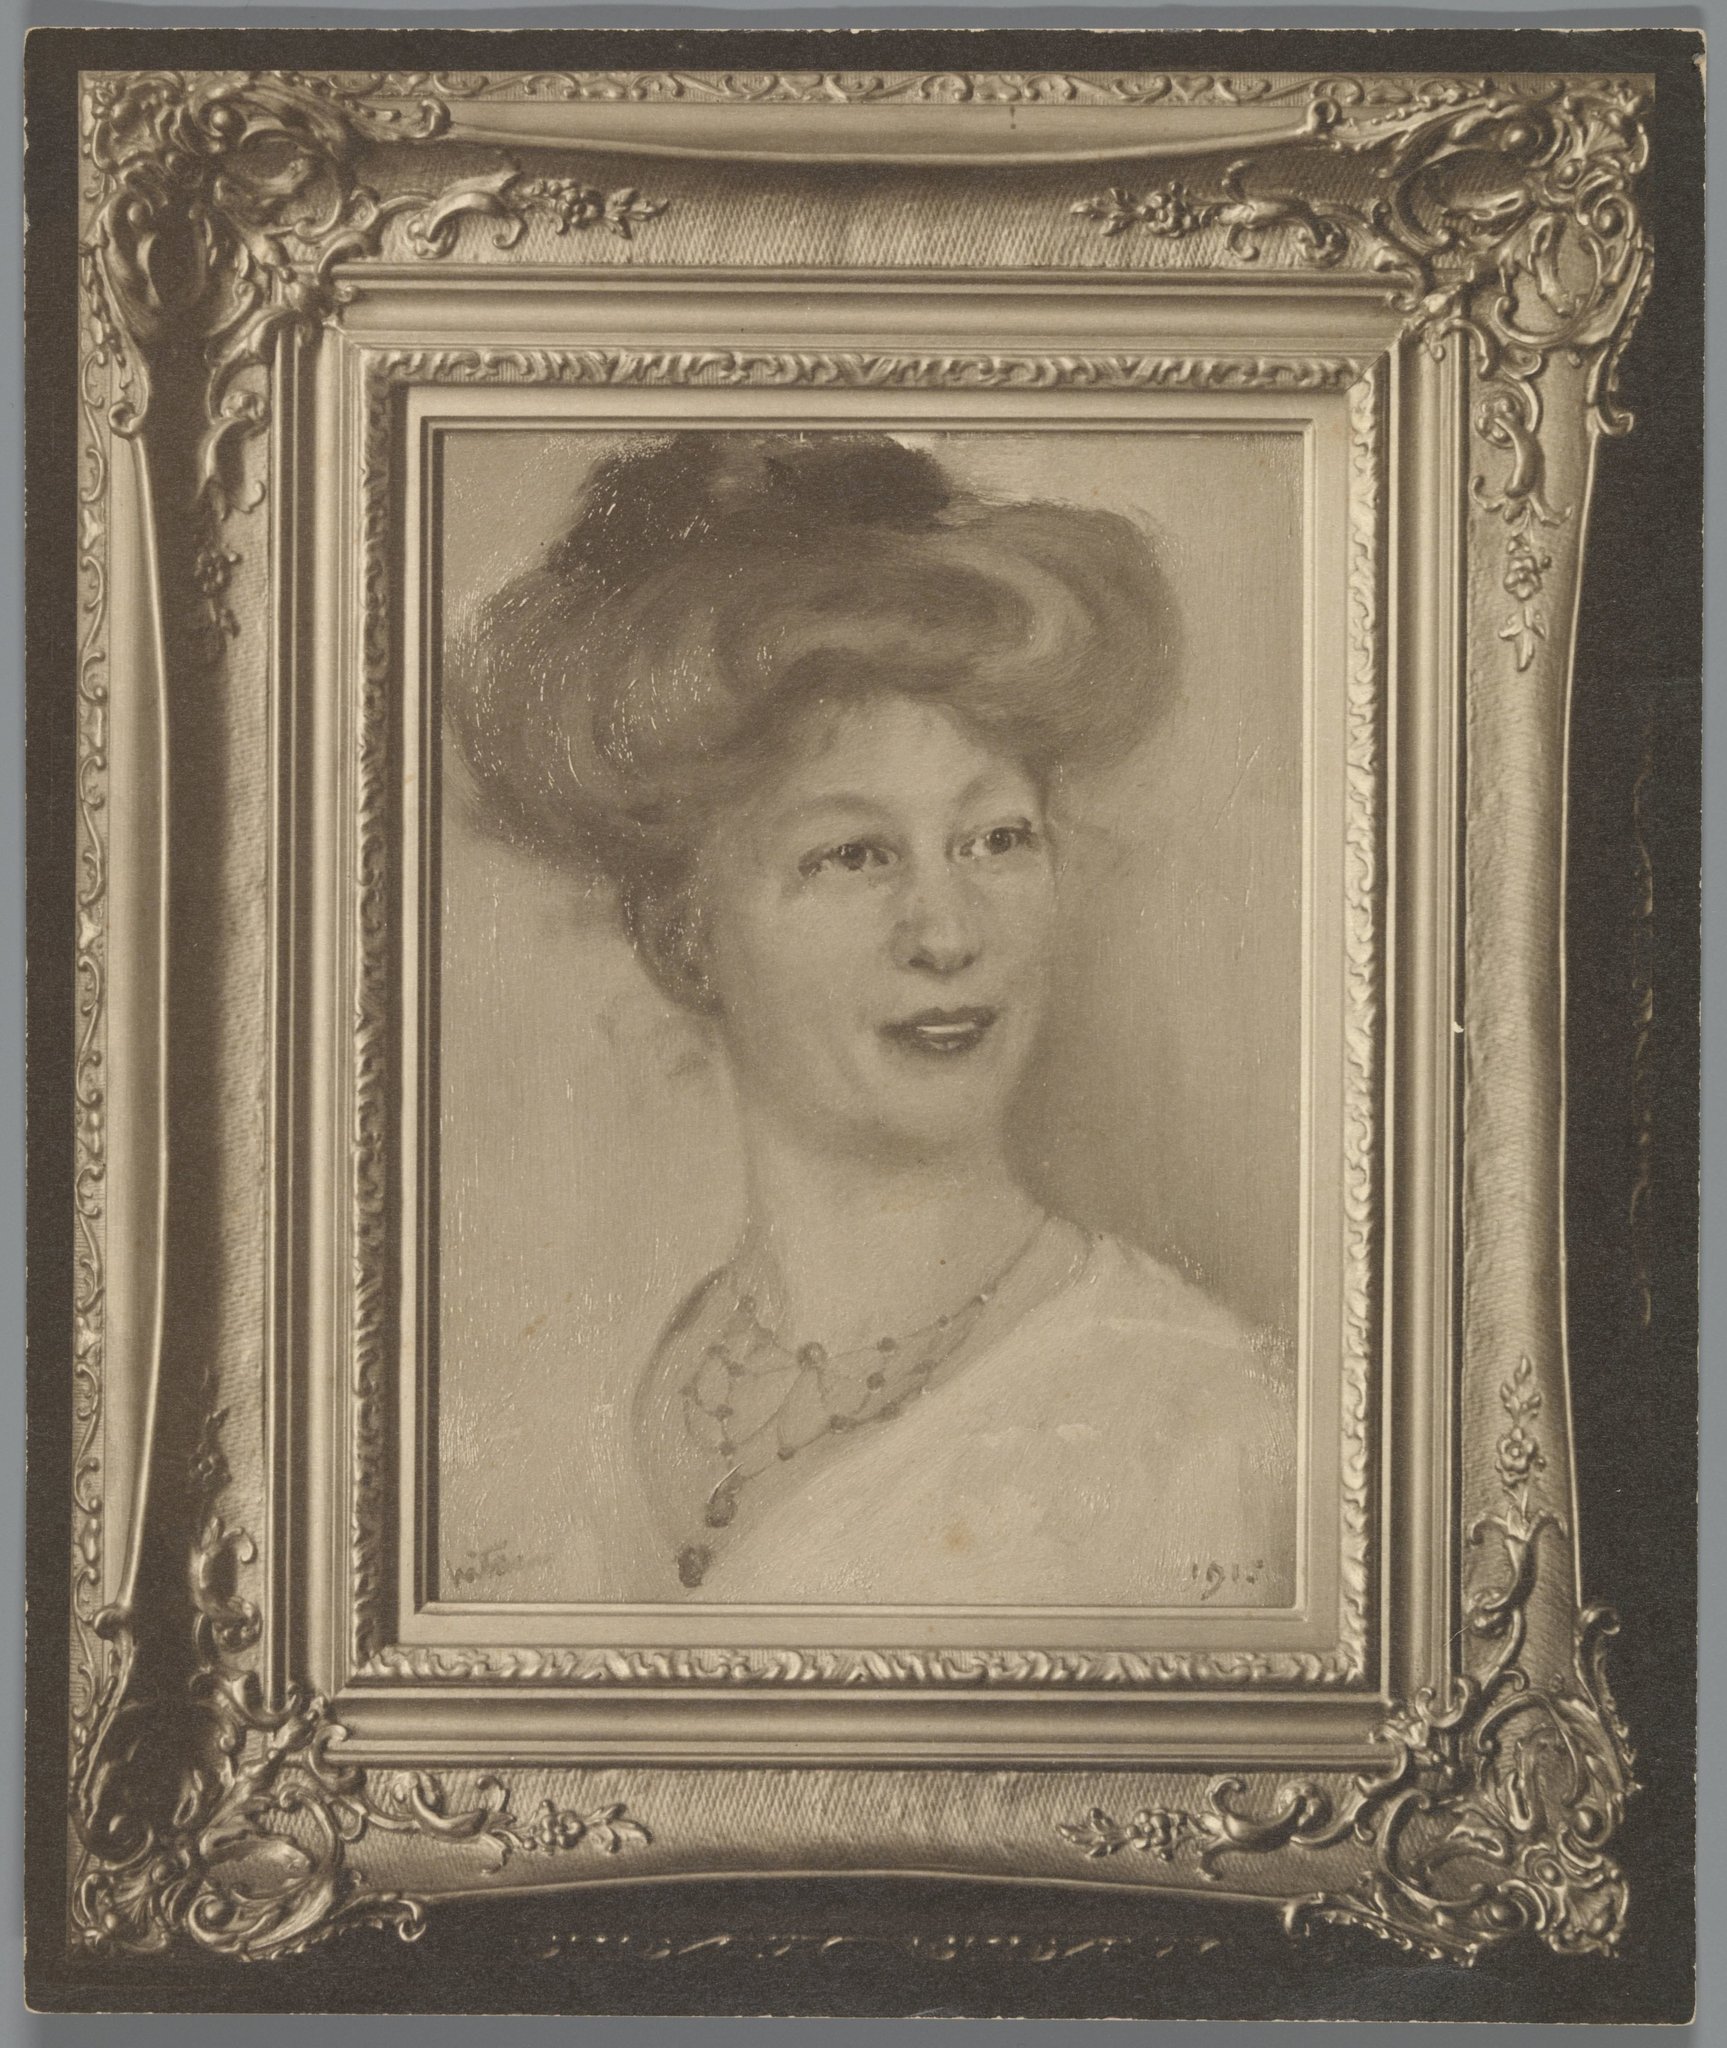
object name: photograph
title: Reproductie naar schilderij van Willem Witsen van een portret van een vrouw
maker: Anonymous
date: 1860-1915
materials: paper, photographic support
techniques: gelatin silver print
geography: netherlands